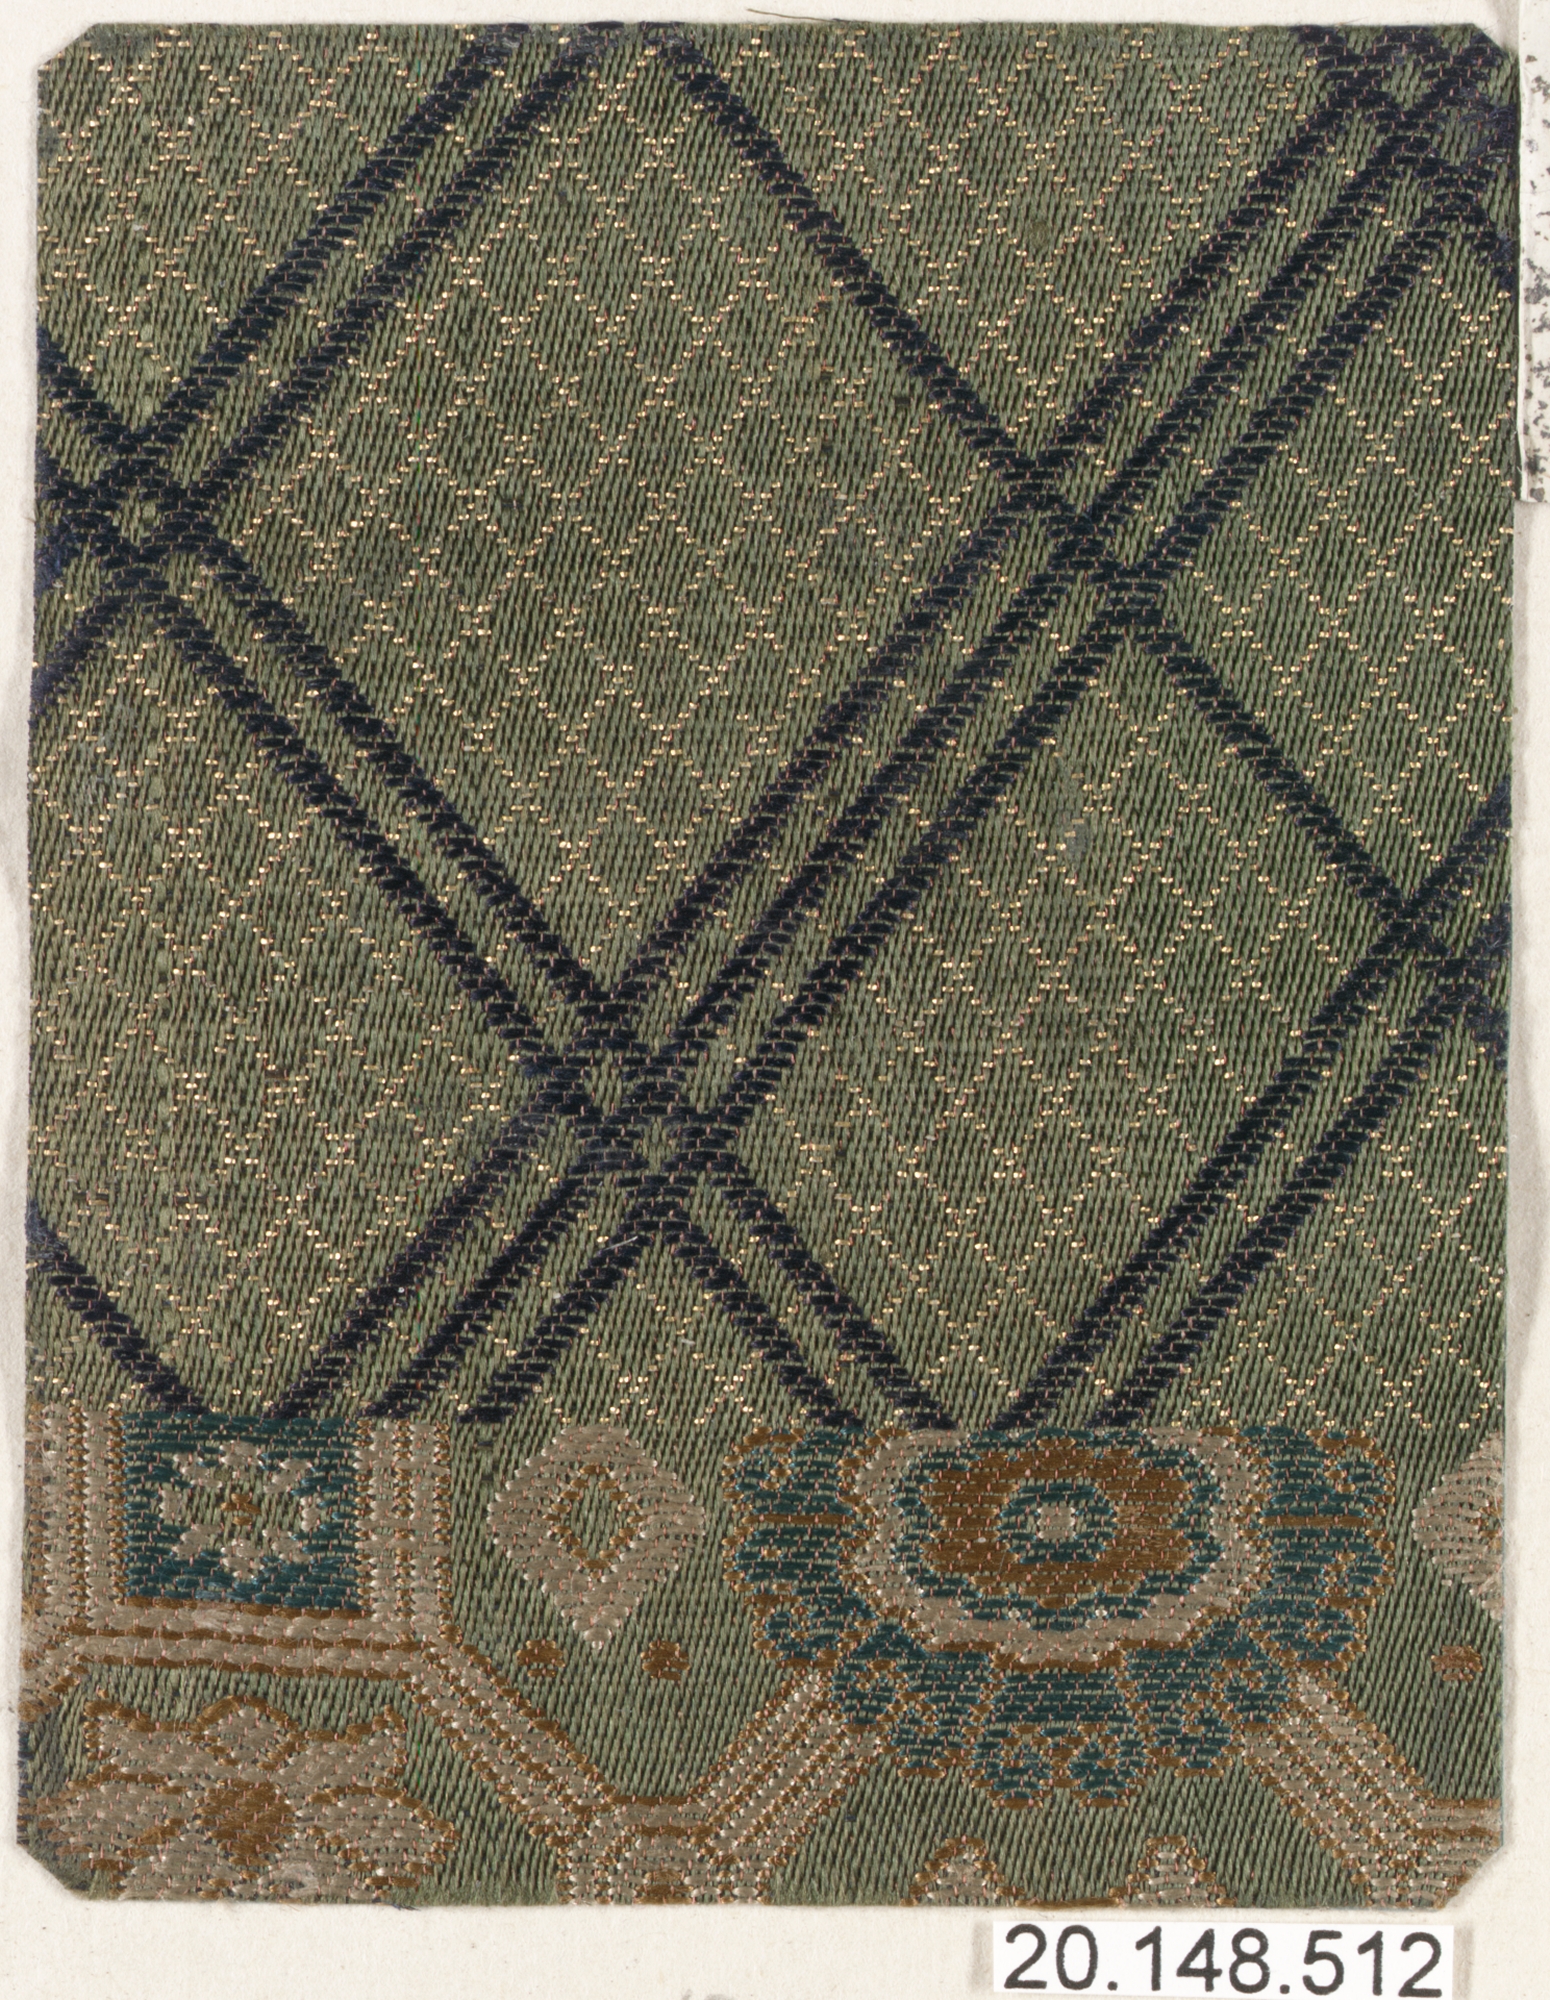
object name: piece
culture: japanese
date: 1701-1800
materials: silk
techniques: compound weave